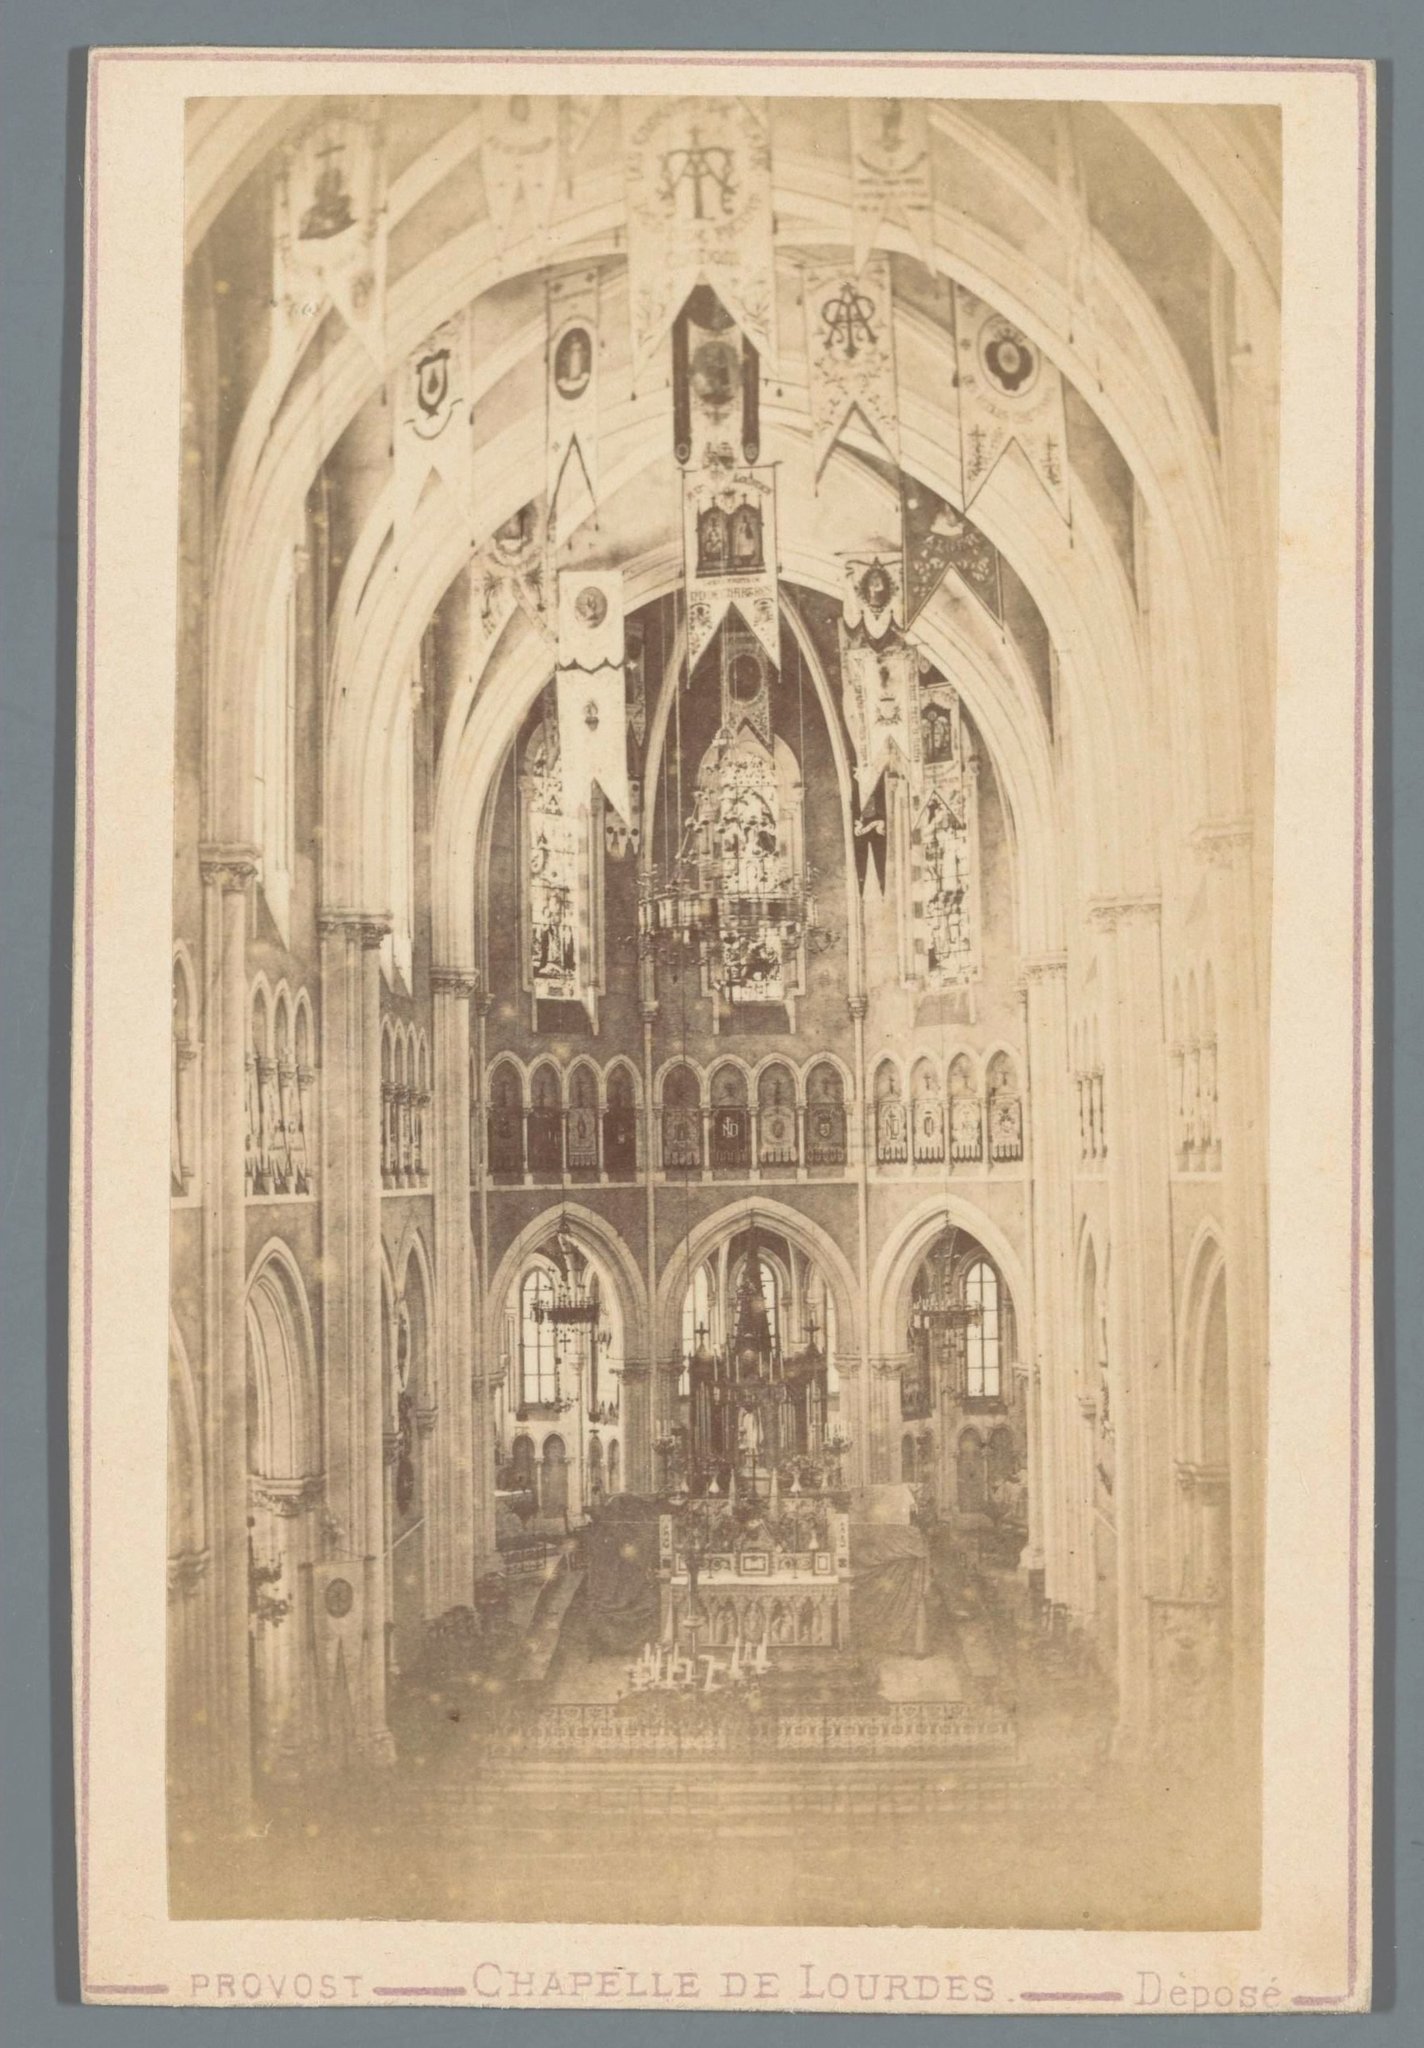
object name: carte de visite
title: Interieur van de kapel van Lourdes, Frankrijk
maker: provost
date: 1872-1900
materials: cardboard, paper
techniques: albumen print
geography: lourdes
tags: parts of church interior: choir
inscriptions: inscription: ‘ROME 1er PRIX/ PHOTOGRAPHIE PROVOST, TOULOUSE./ PRIÈRE À NOTRE-DAME DE LOURDES/ Soyez bénie, Vierge très-pure, qui avez/ (...)/ A.N.~D. de Poueylaün en tournée/ pastorale le 4 Mai 1872./ P.A., Ev. de Tarbes./ Déposé’, inscription: ‘PROVOST Déposé’